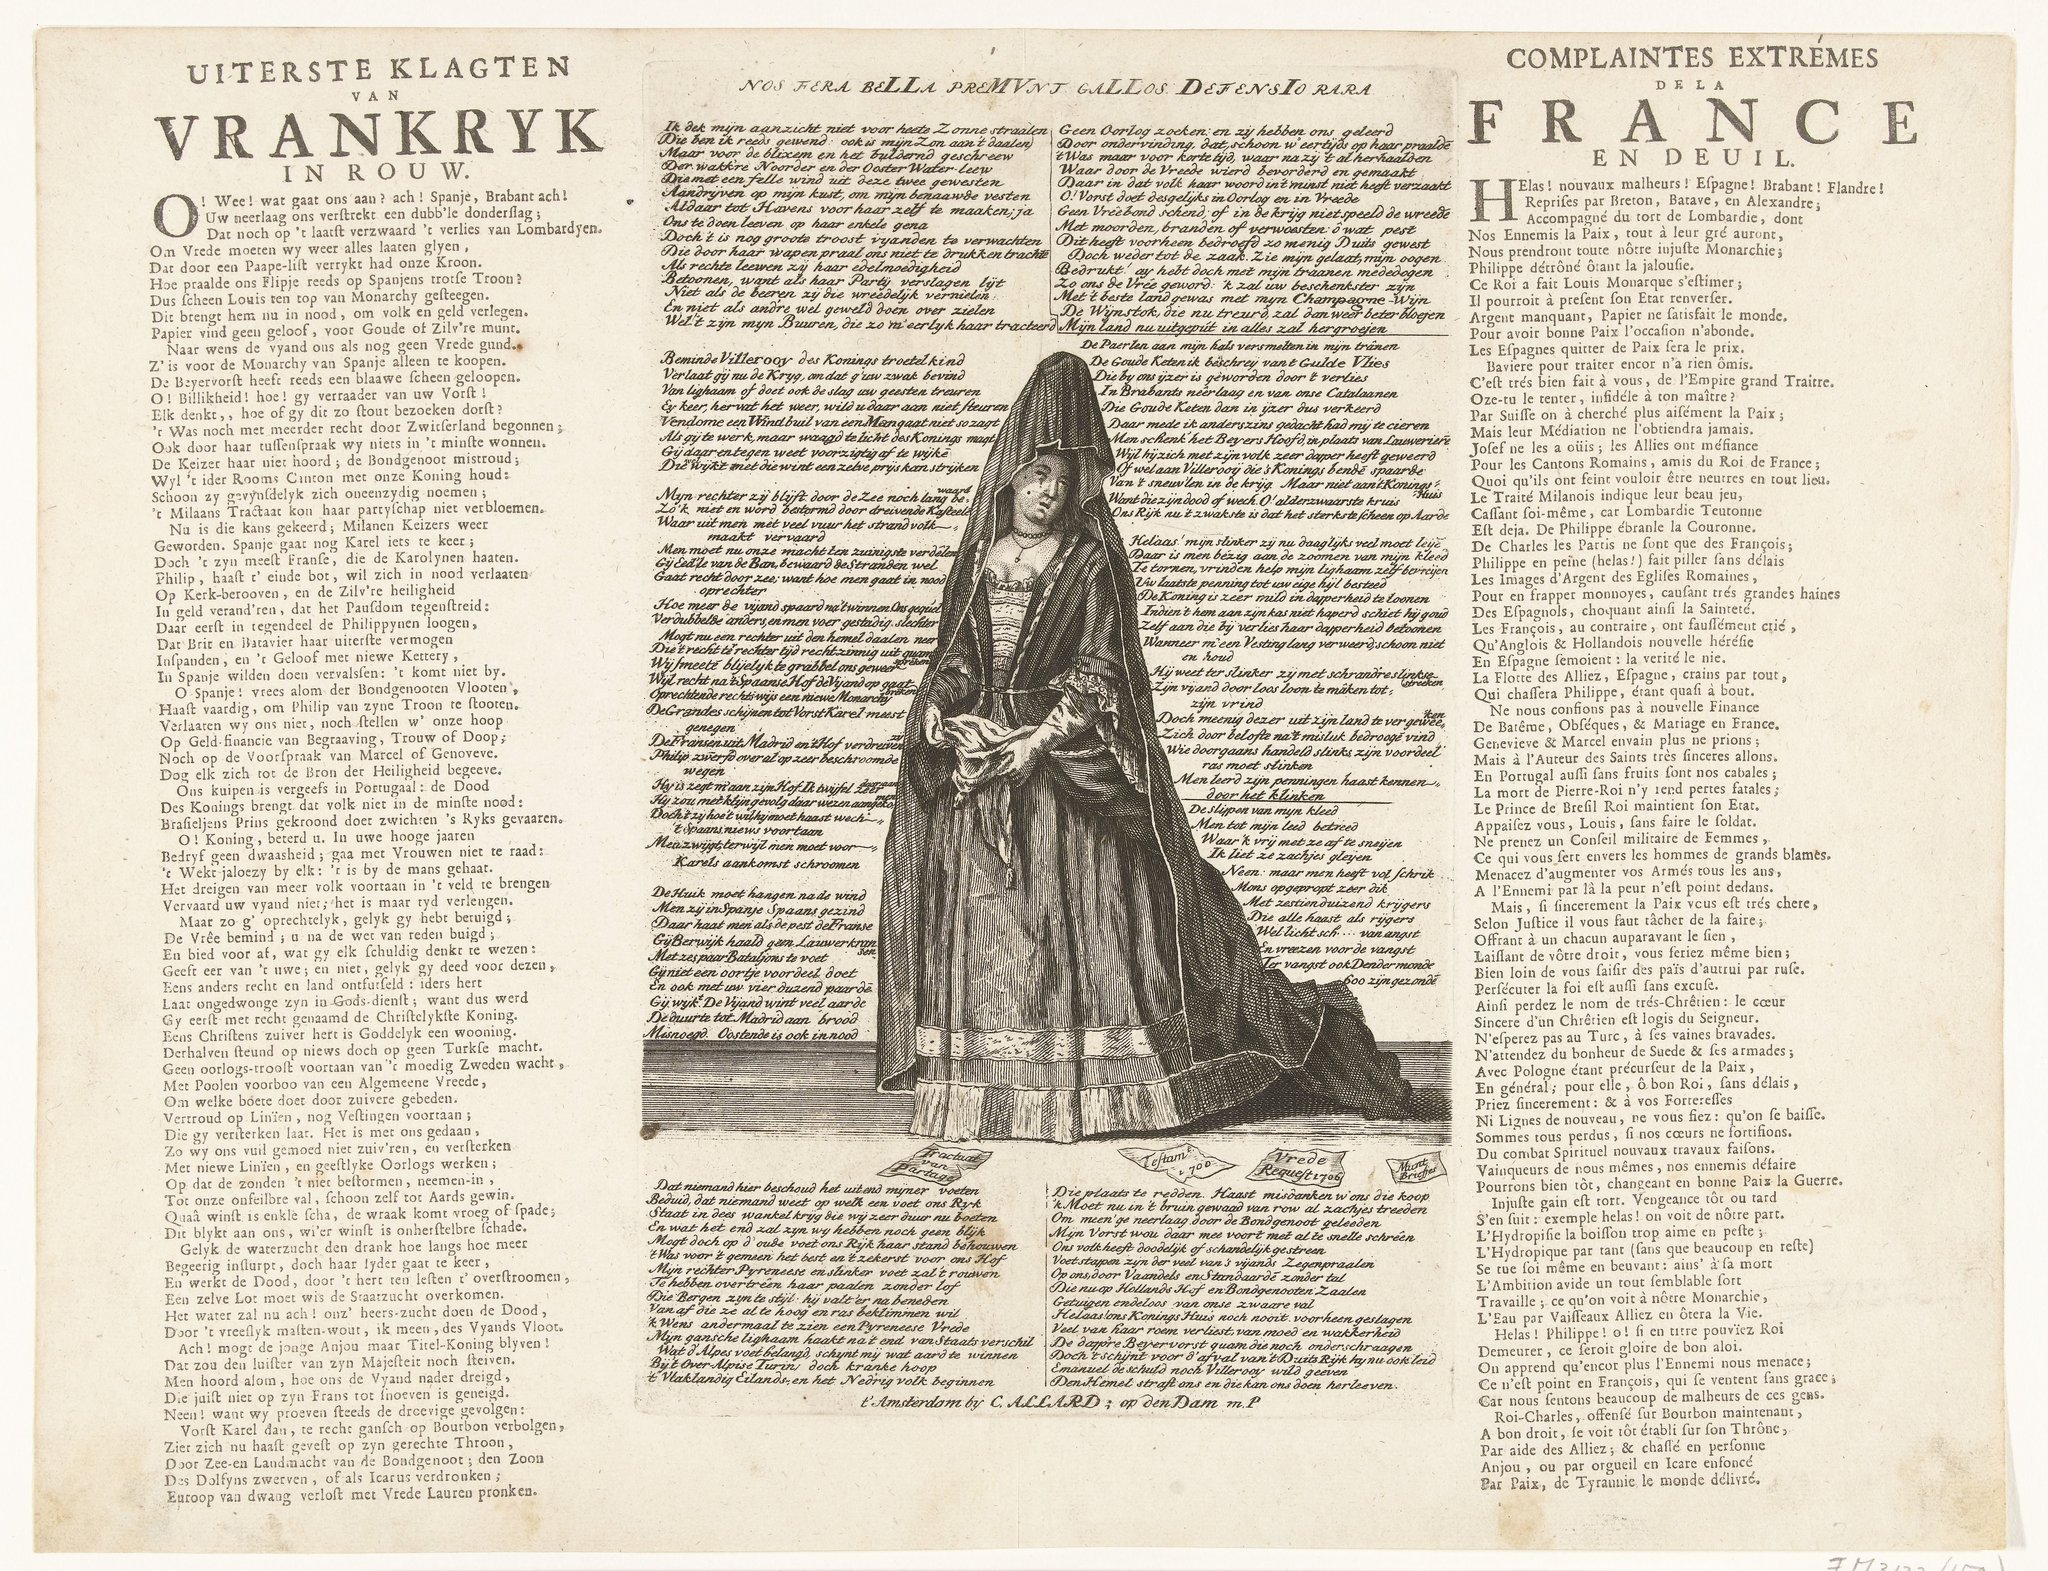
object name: print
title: Koninklijke Almanach van 1706 / 't Lusthof van Momus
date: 1706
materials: paper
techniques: etching, letterpress printing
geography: amsterdam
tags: madame de maintenon, political caricatures and satires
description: Madame de Maintenon als het klagende Frankrijk, staande ten voeten uit, gekleed als een weduwe. In de plaat verzen in het Nederlands, op het blad gedrukt 2 kolommen tekst in het Nederlands en Frans. Spotprent op de situatie in het jaar 1706 in de Spaanse Successieoorlog. Onderdeel van een reeks van 25 spotprenten op de Fransen en bondgenoten uit het jaar 1706.